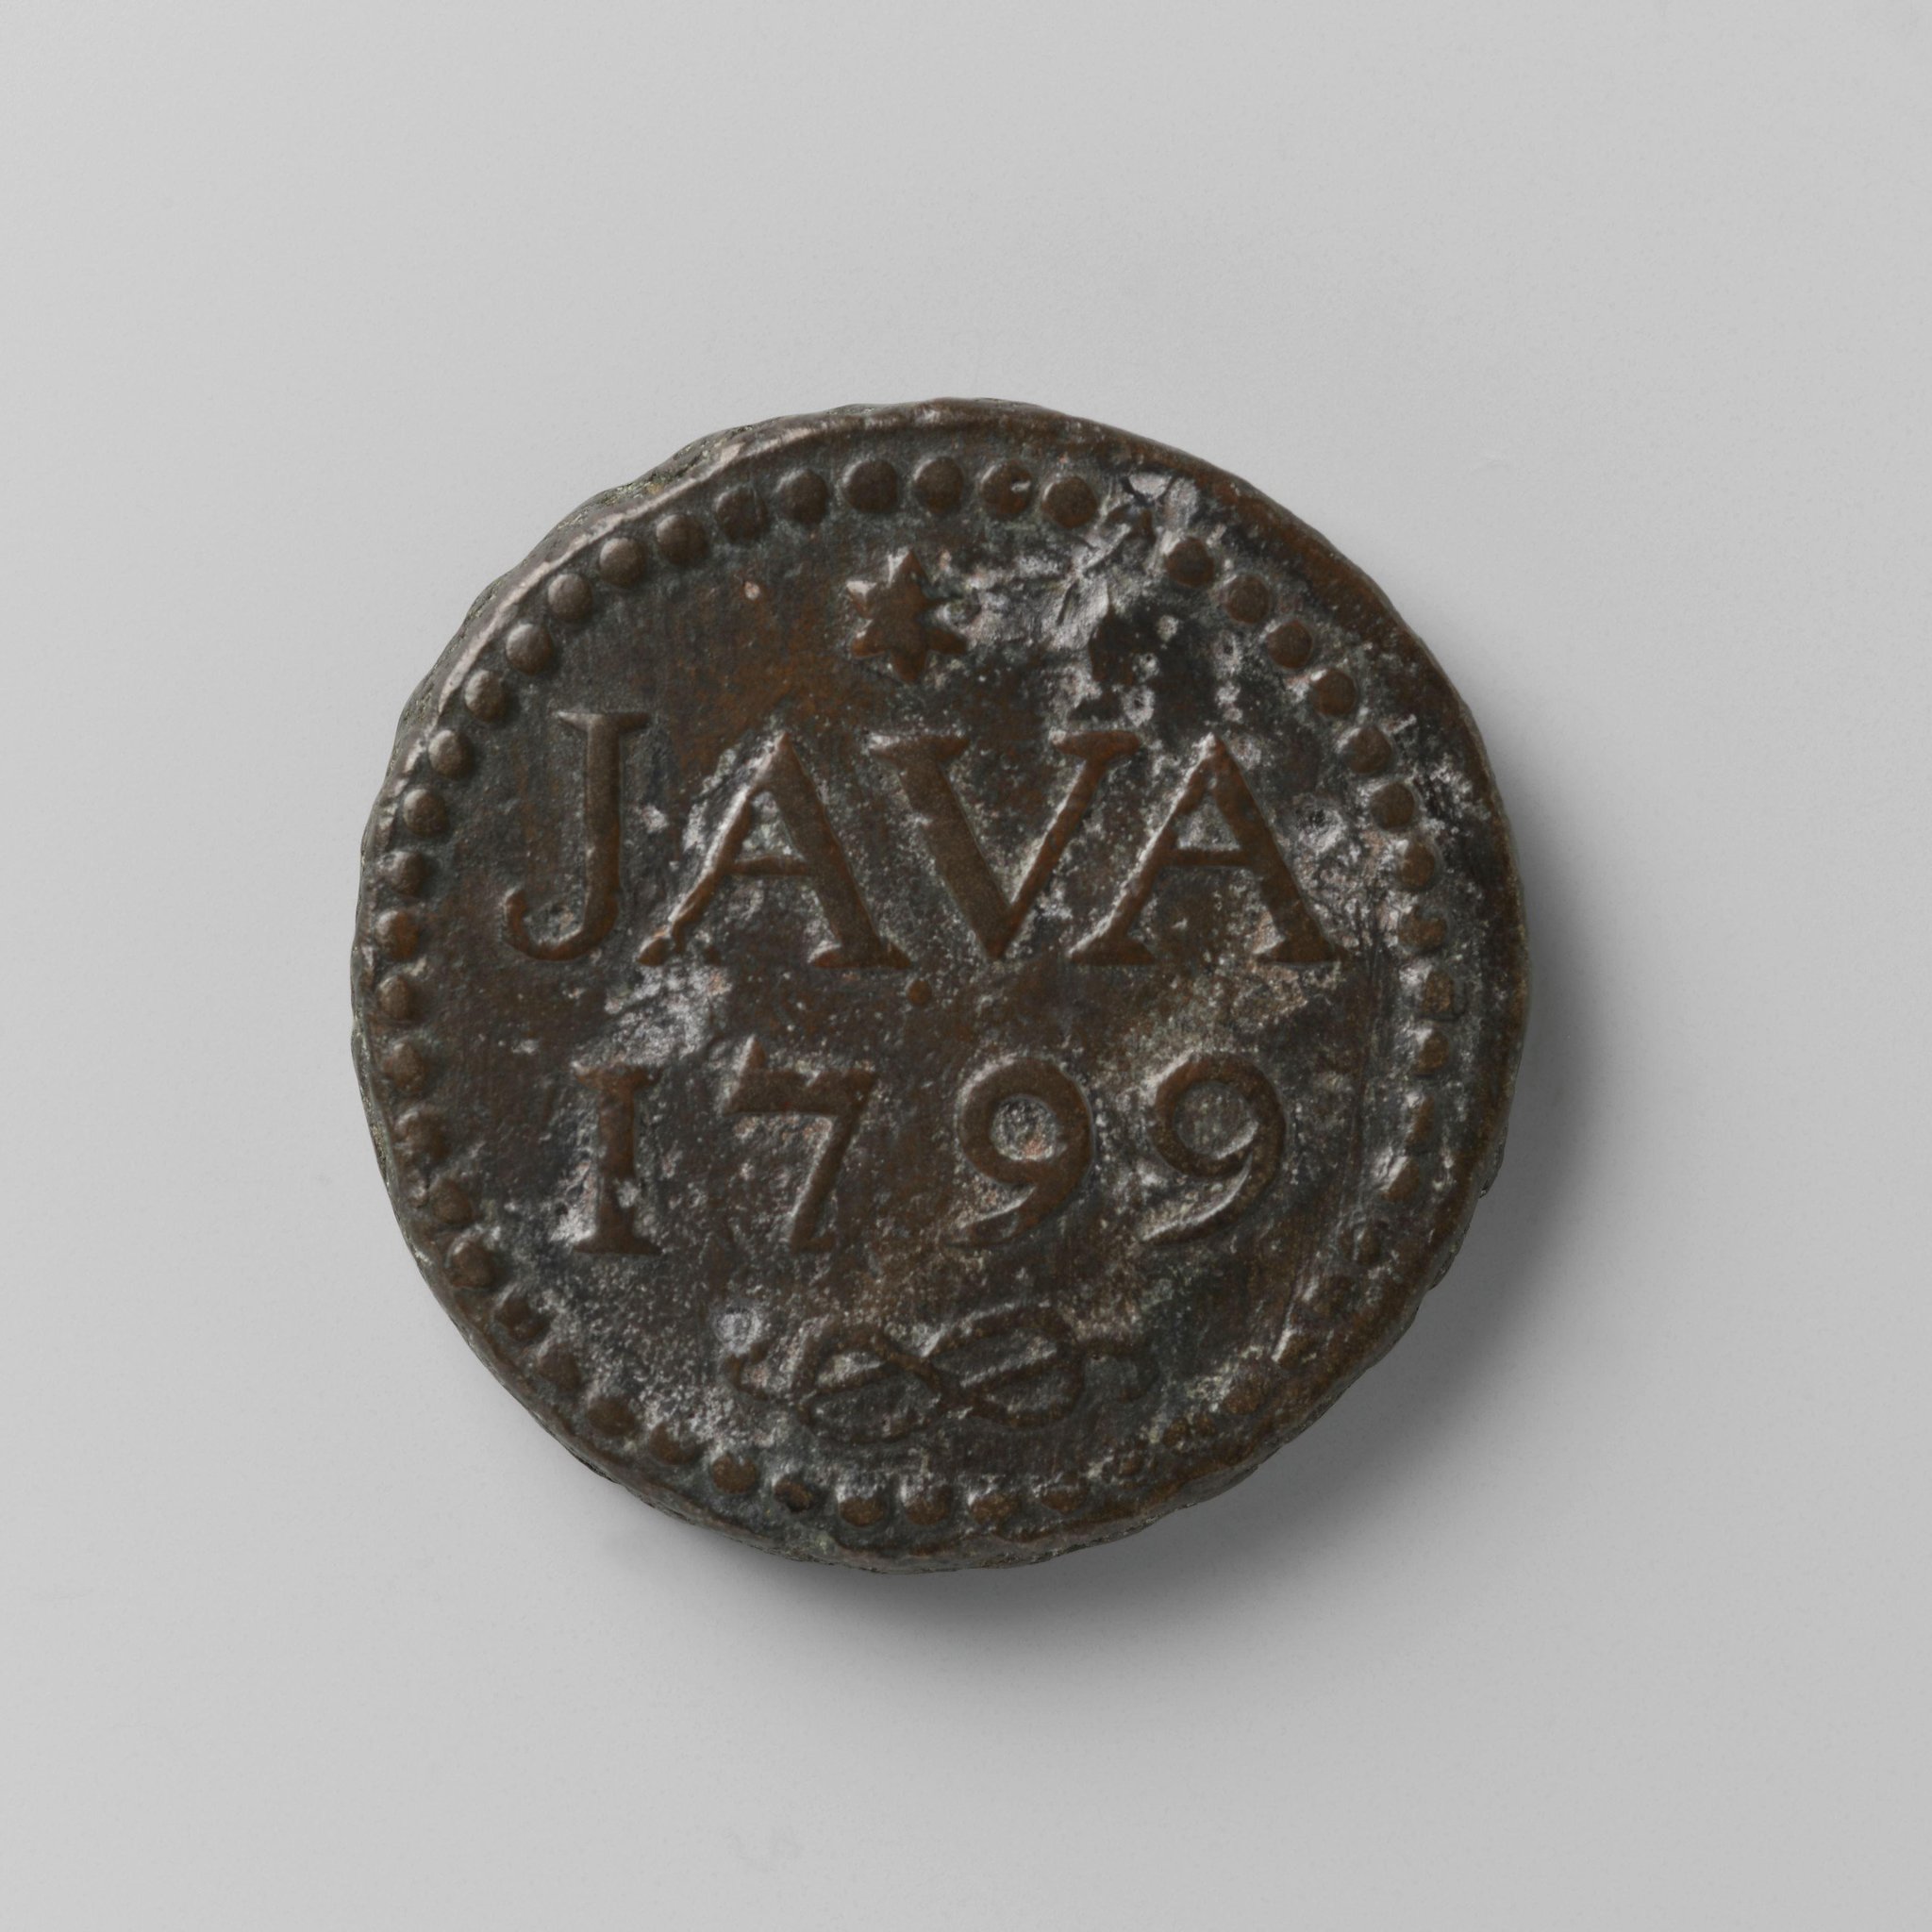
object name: stuiver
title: Nederlands Indië, stuiver, noodmunt, 1799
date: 1799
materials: bronze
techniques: striking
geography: batavia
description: Bronzen noodmunt. Voorzijde: opschrift: JAVA, waarboven muntteken en waaronder jaartal. Daaronder touwstrik. Keerzijde: waarde-aanduiding I St., waarboven muntteken en waaronder touwstrik. Kabelrand.